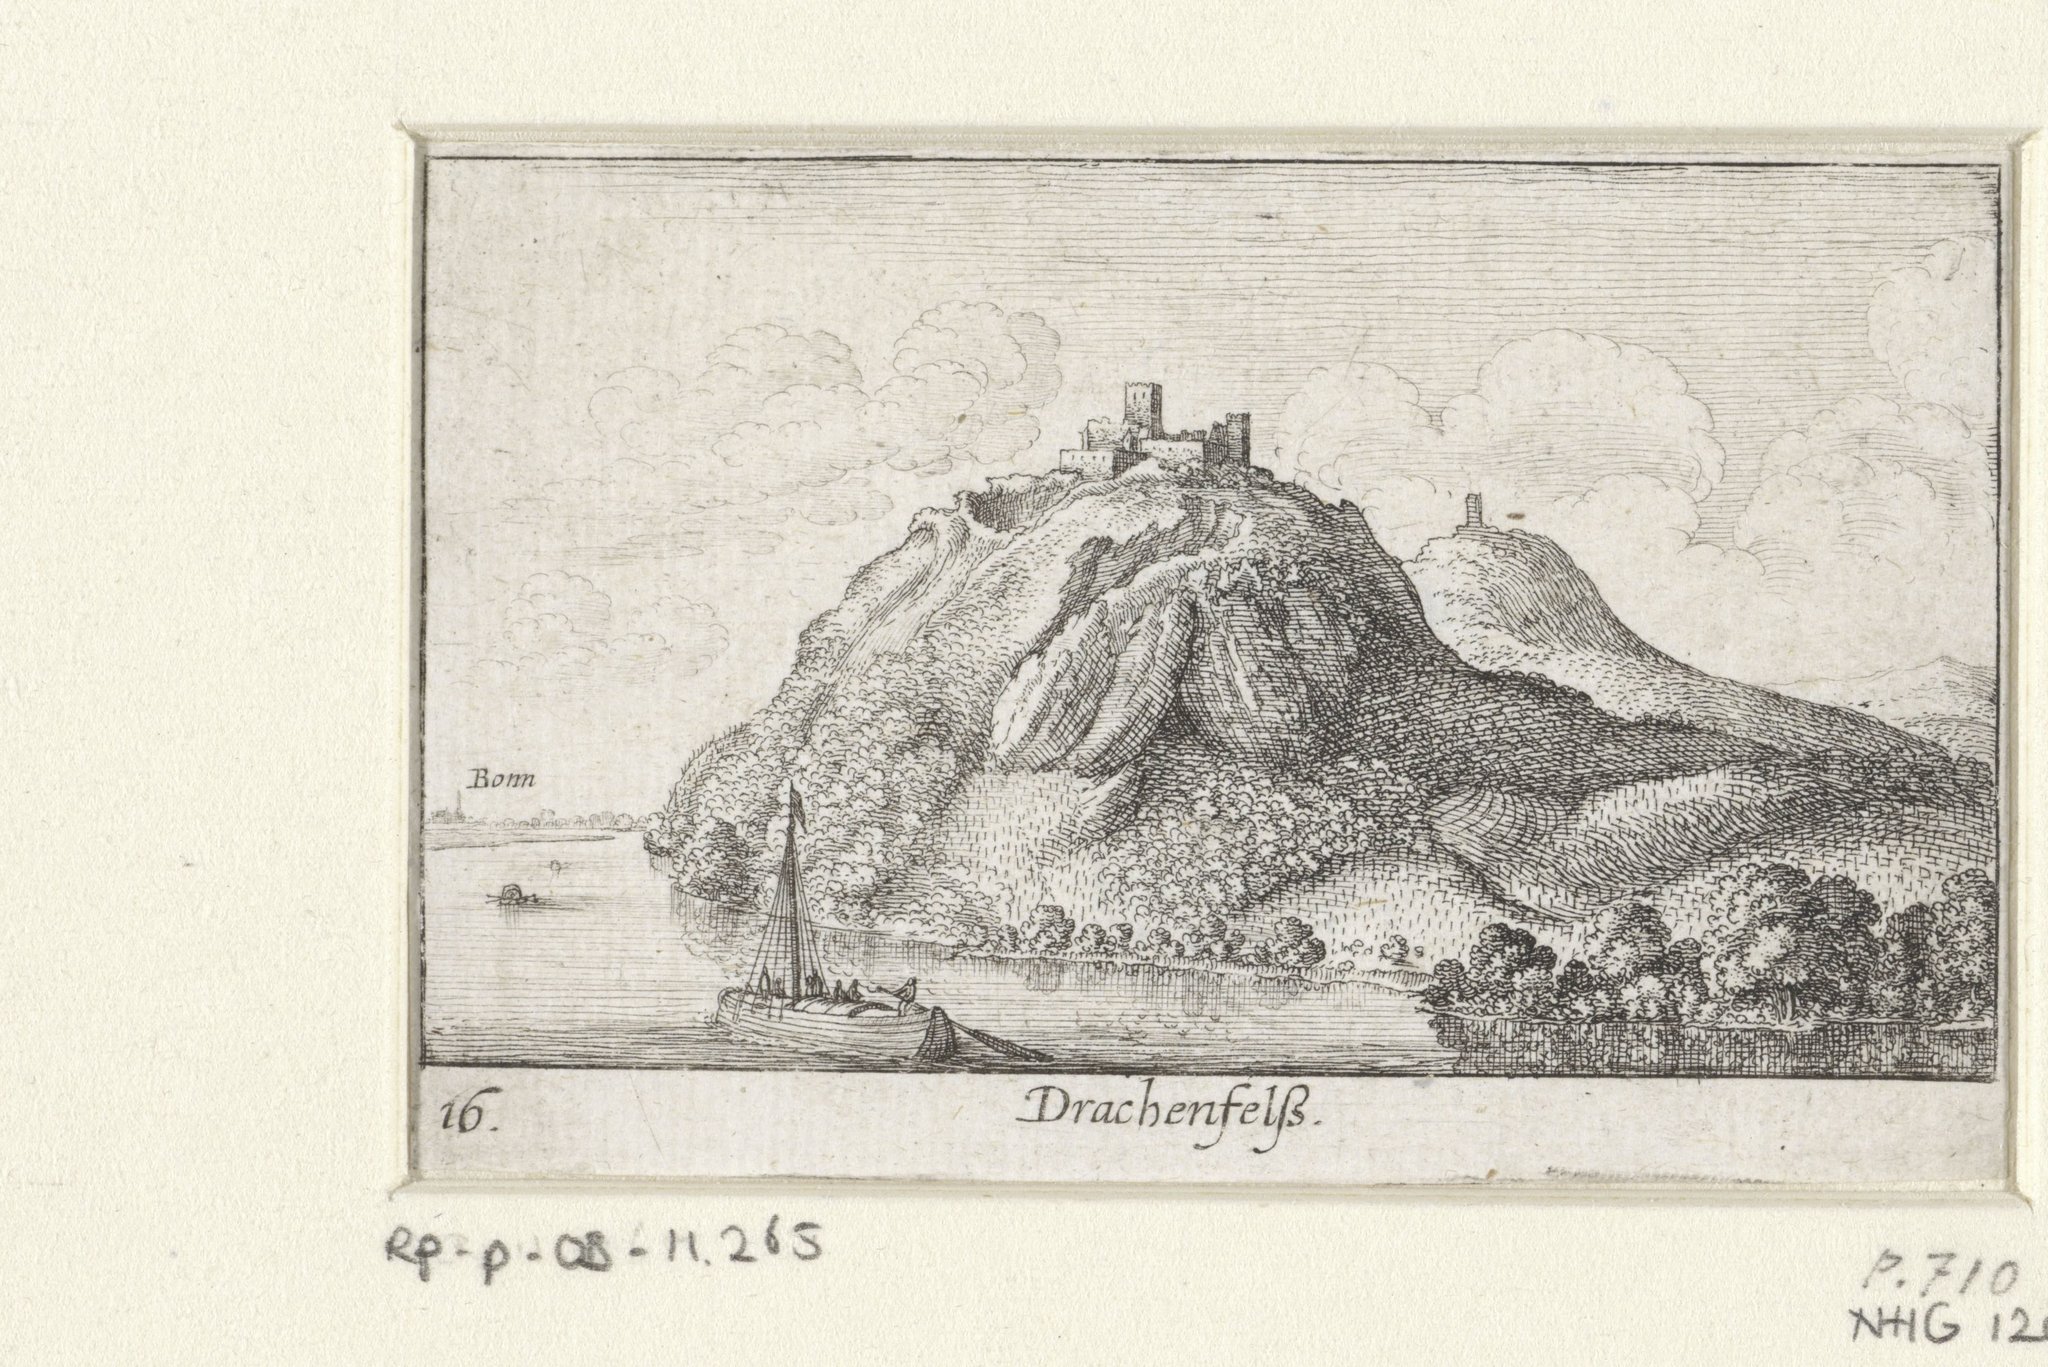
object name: print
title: Gezicht op de Drachenfels aan de Rijn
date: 1635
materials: paper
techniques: etching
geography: cologne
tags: city-view, and landscape with man-made constructions